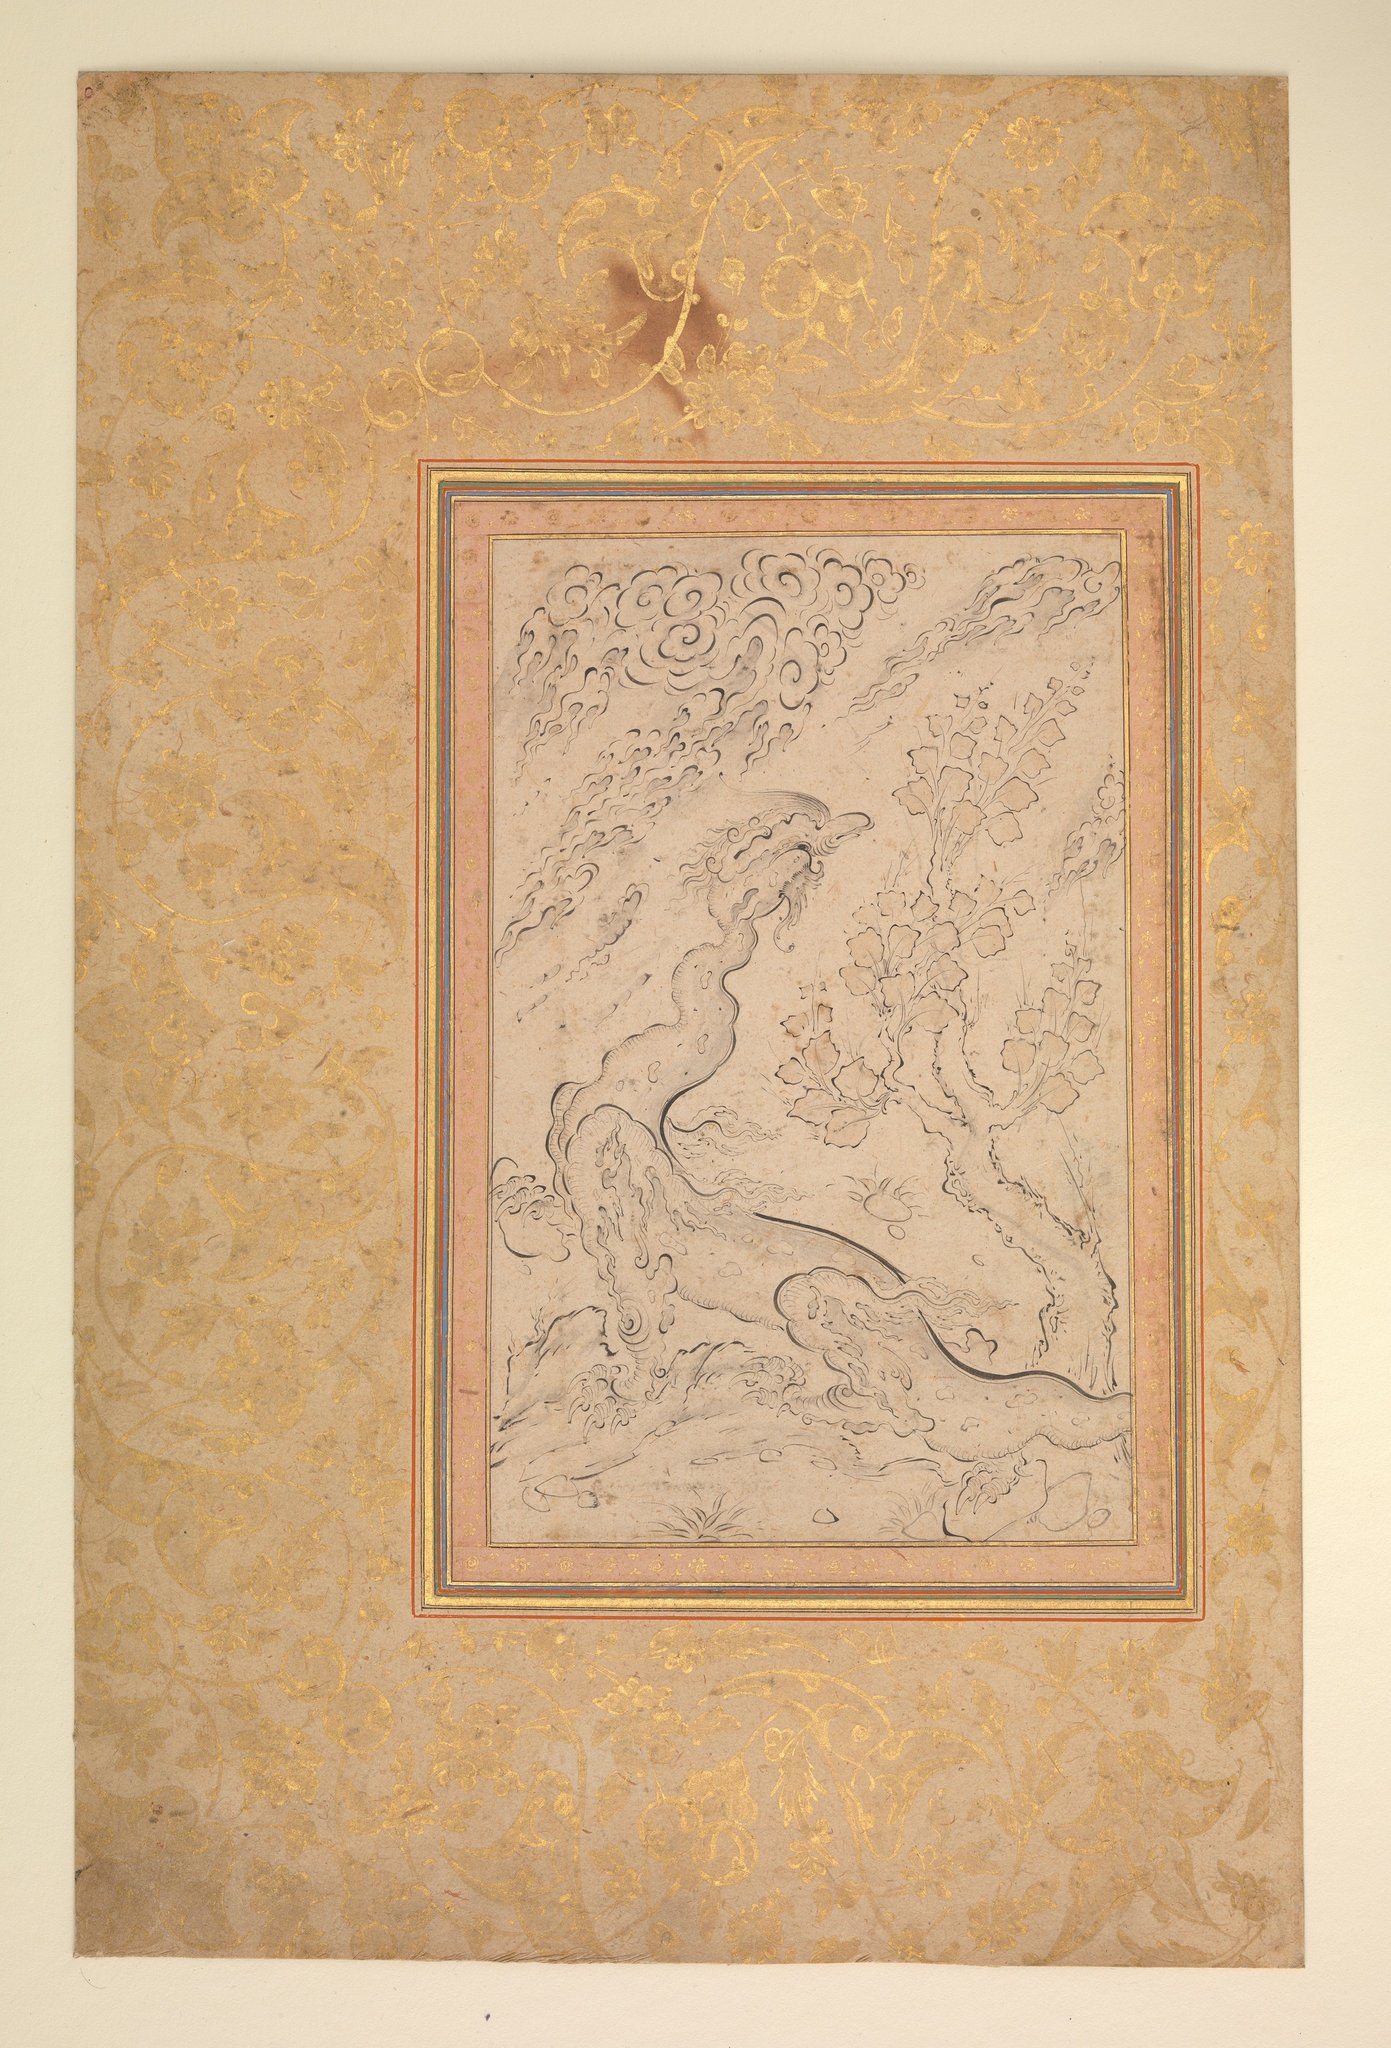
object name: illustrated single work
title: Dragon and Clouds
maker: sadiqi beg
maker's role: artist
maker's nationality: iranian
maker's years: 1508-1635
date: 1600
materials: ink, paper, watercolor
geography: iran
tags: dragons